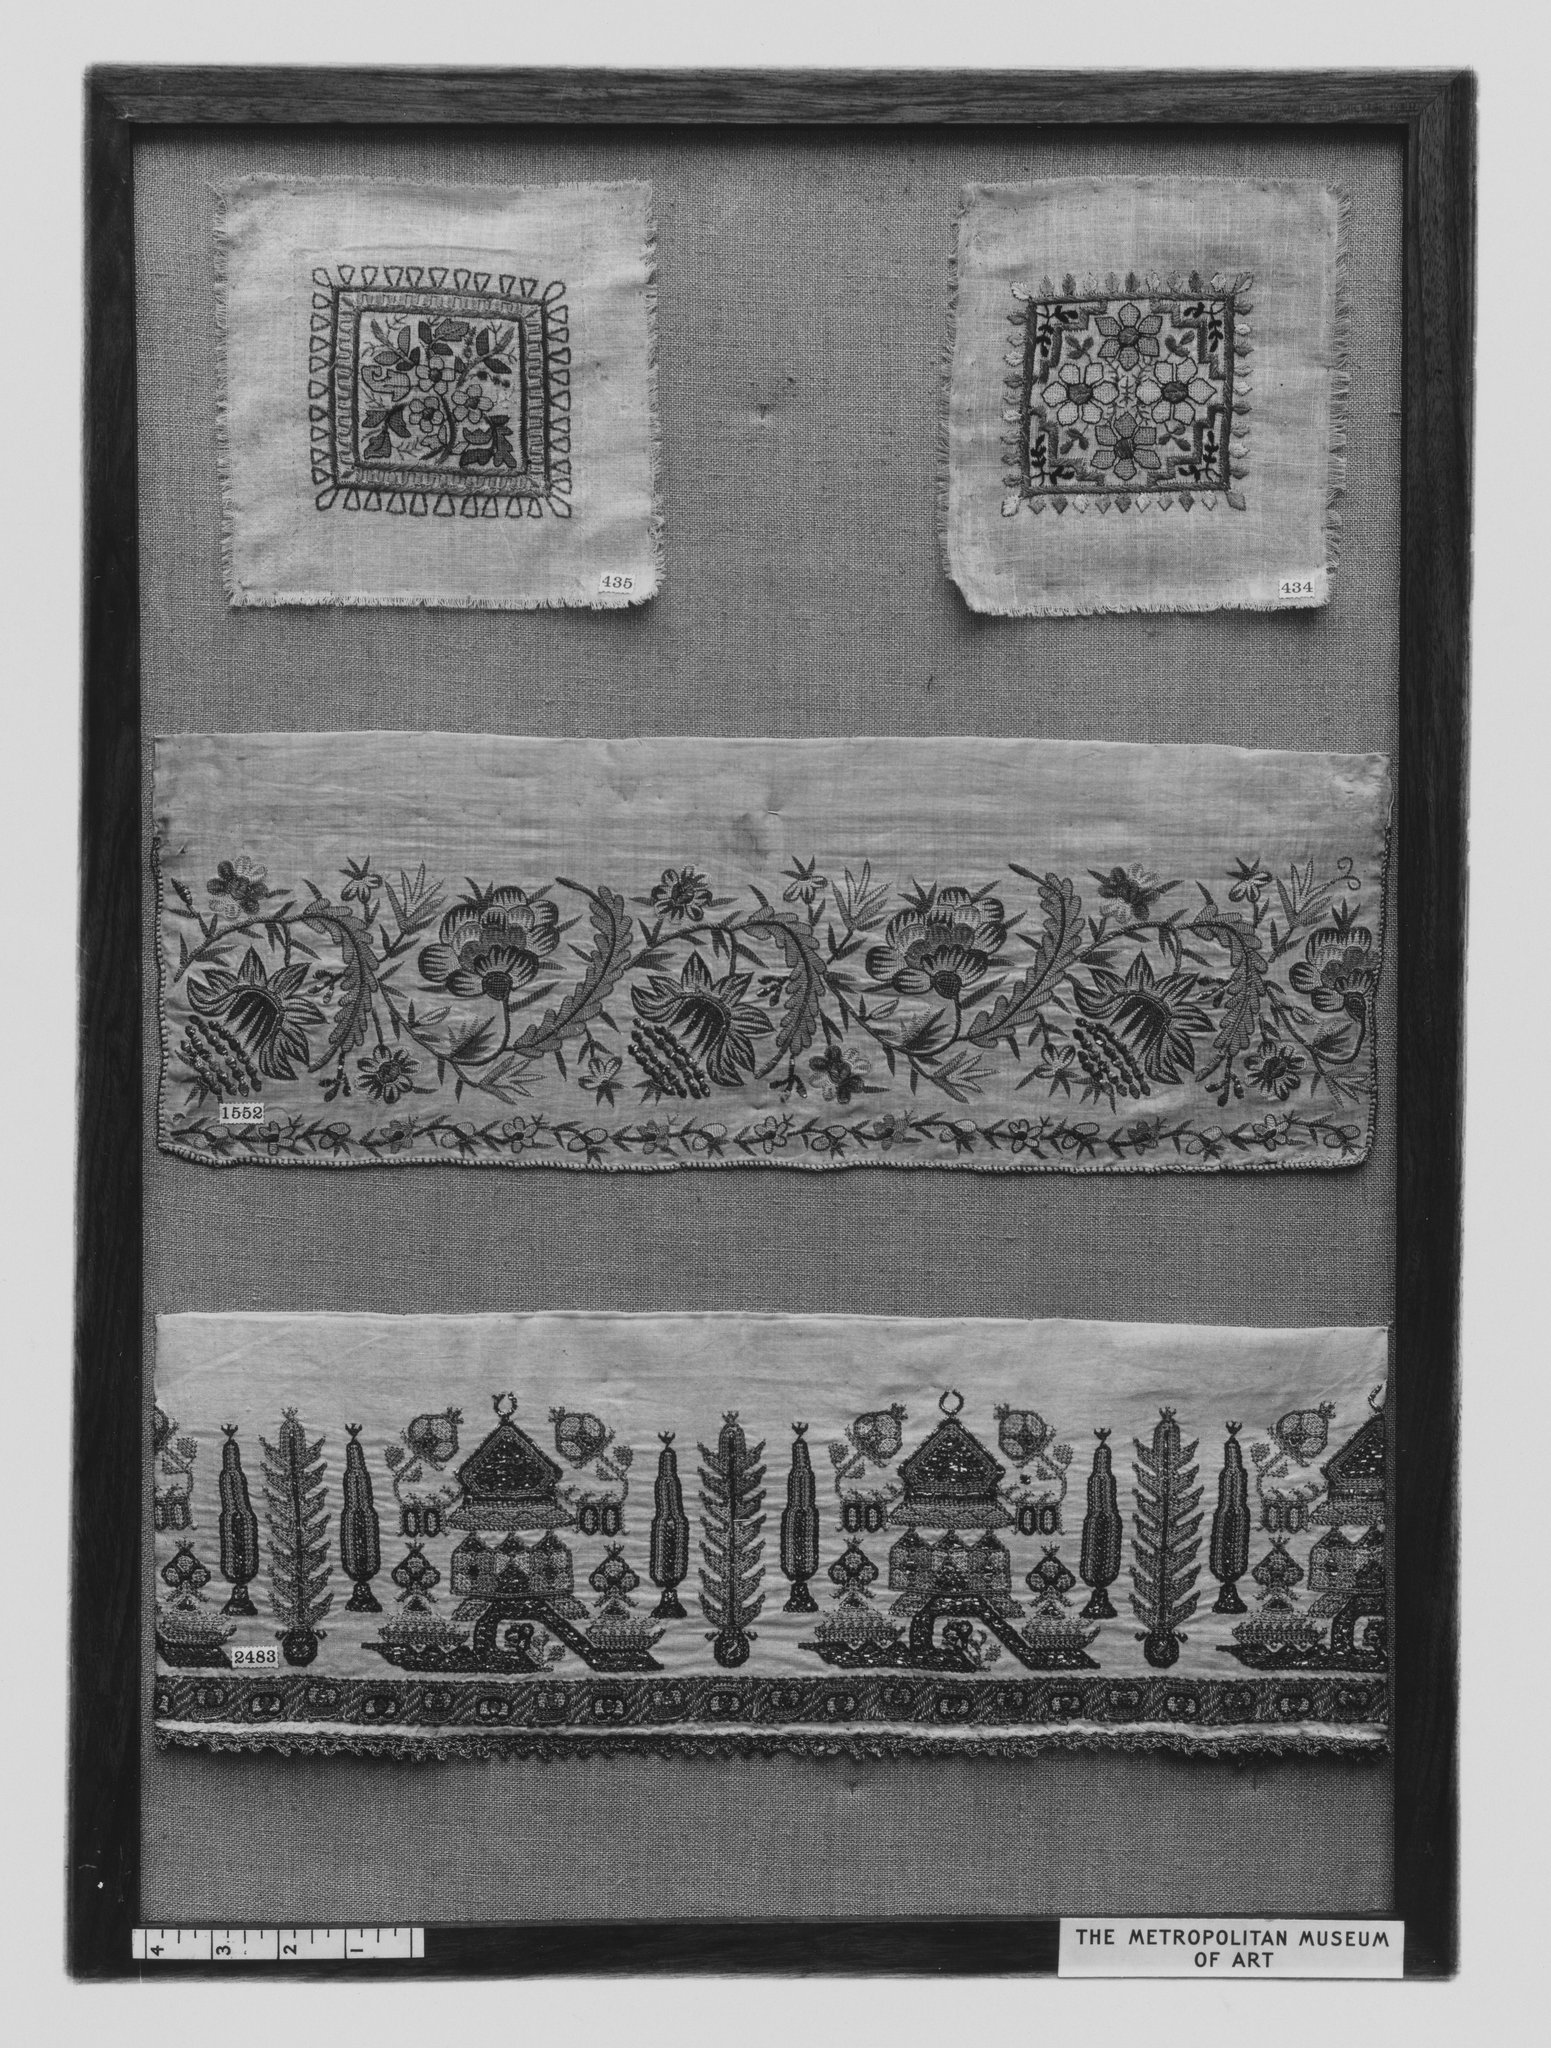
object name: towel end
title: Towel Ends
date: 1801-1900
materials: linen, metal thread, silk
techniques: embroidery, weave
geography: turkey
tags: flowers,leaves